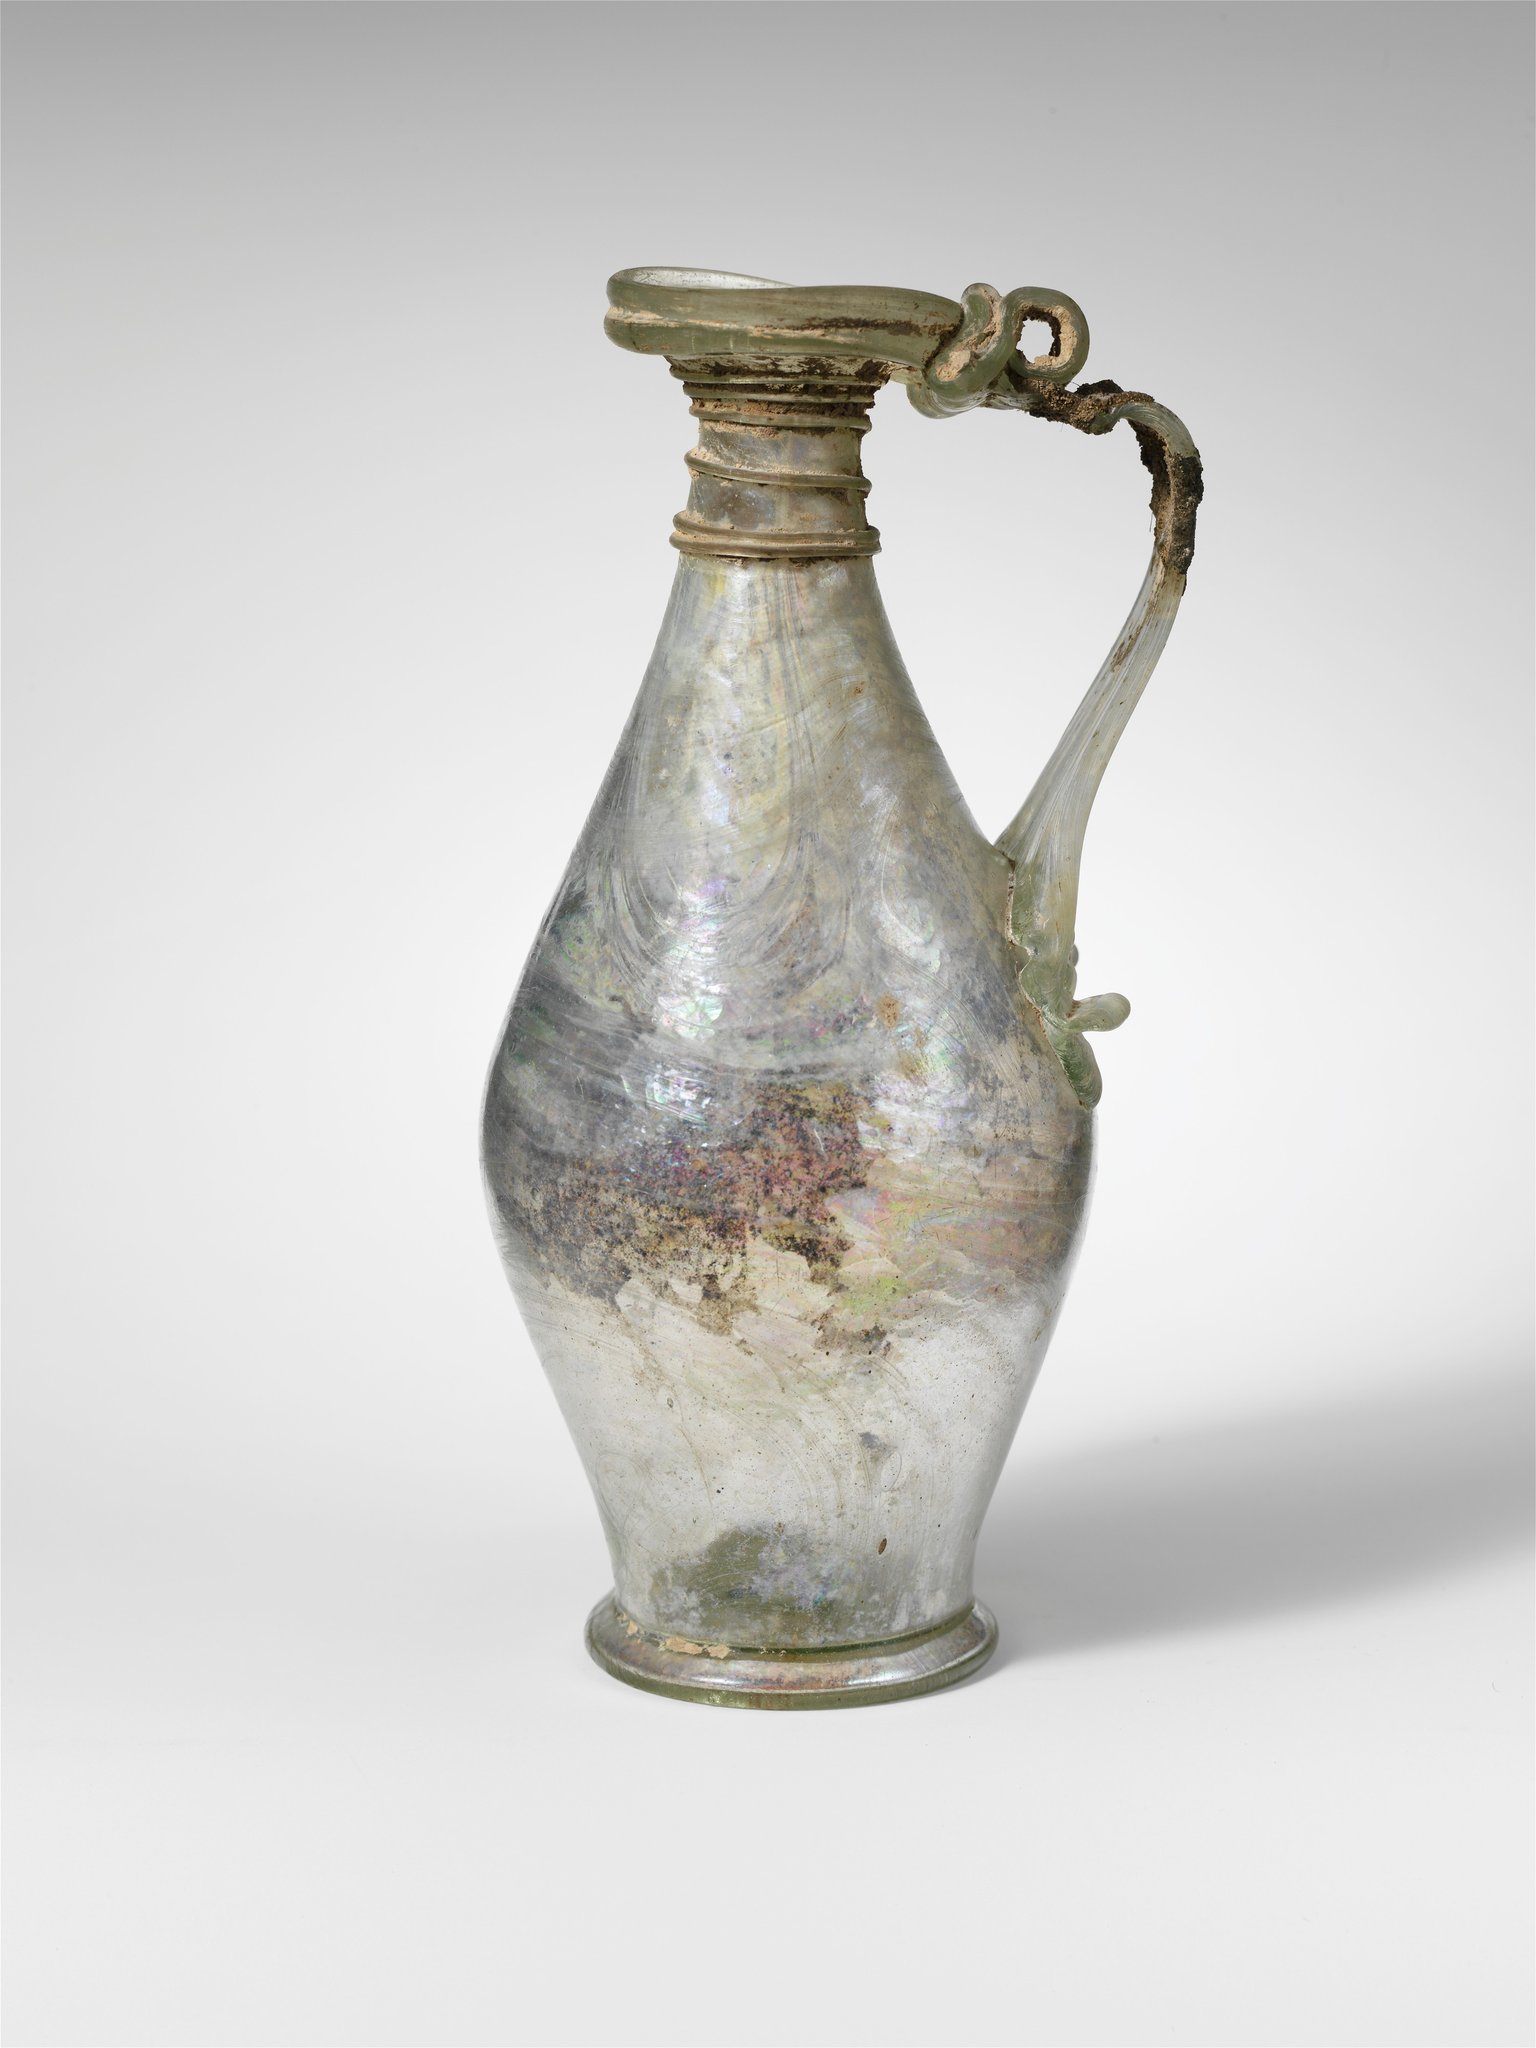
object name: jug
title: Glass jug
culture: roman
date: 201-400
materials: glass